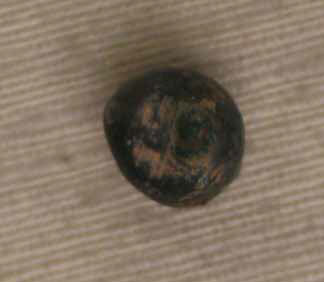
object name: bead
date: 701-1300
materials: ceramic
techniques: glazing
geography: iran